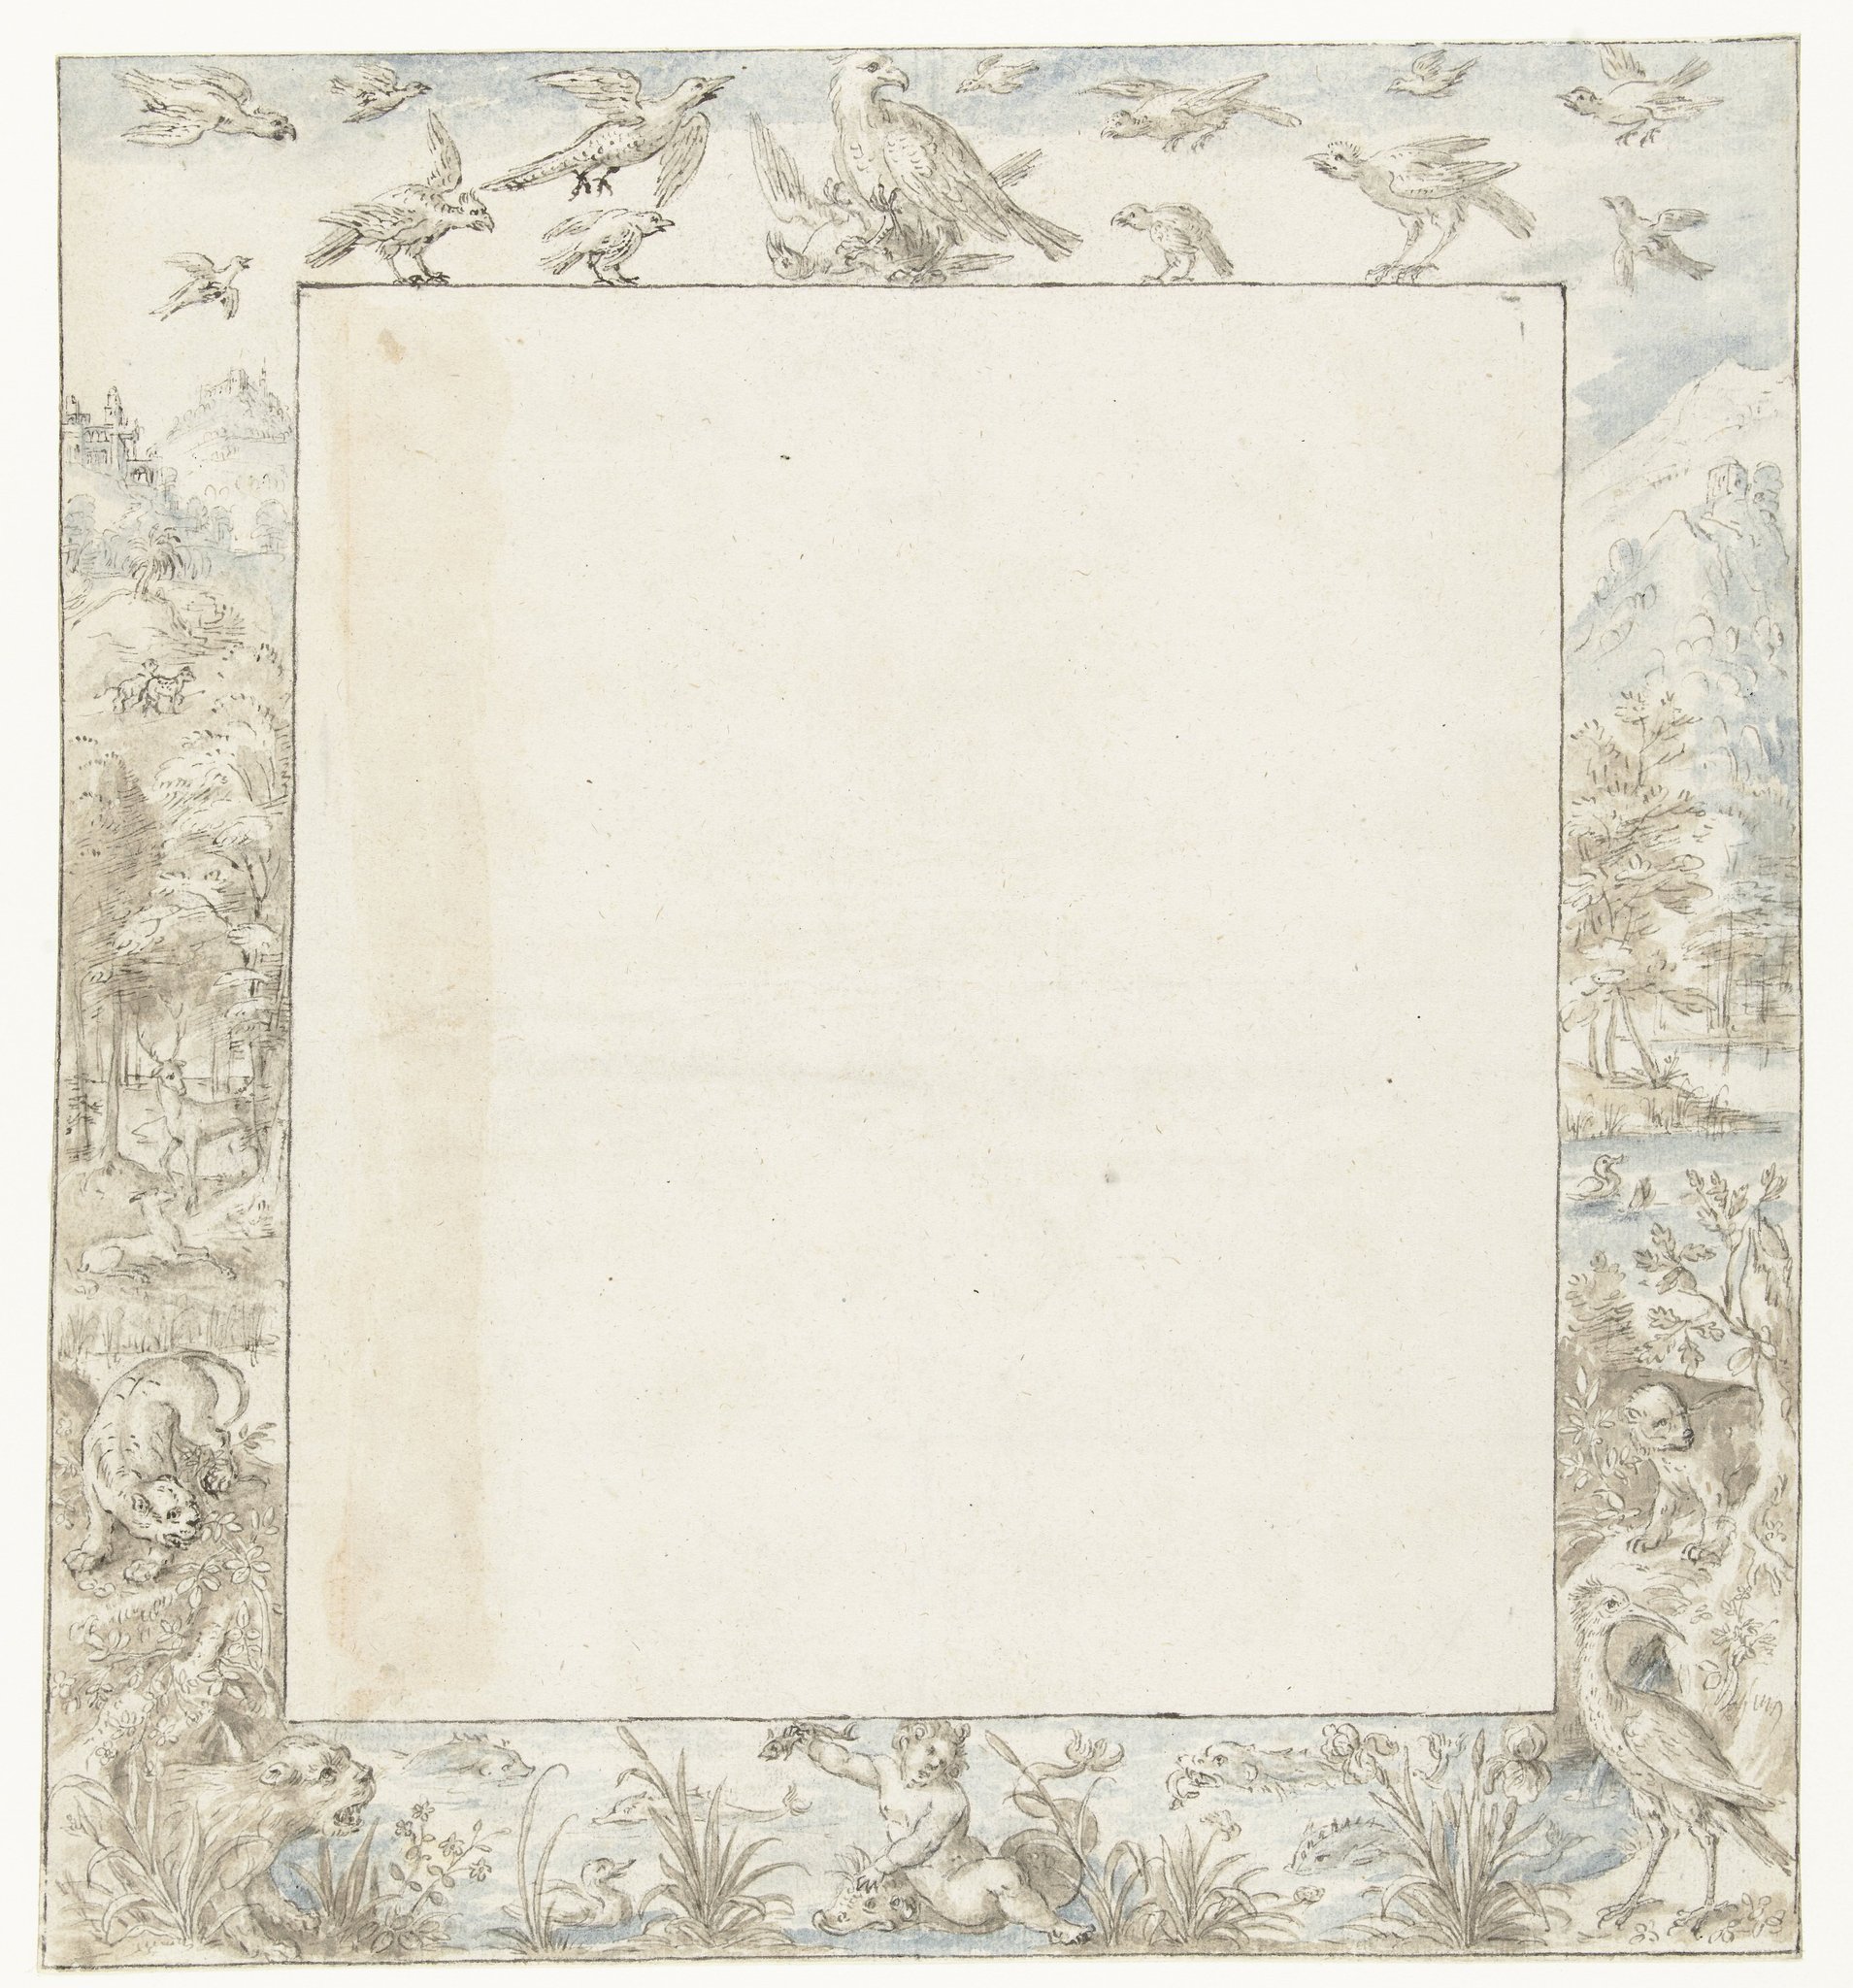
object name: drawing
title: Randdecoratie met vogels en dieren in een landschap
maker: Anonymous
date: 1590-1610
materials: paper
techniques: brush, pen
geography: low countries